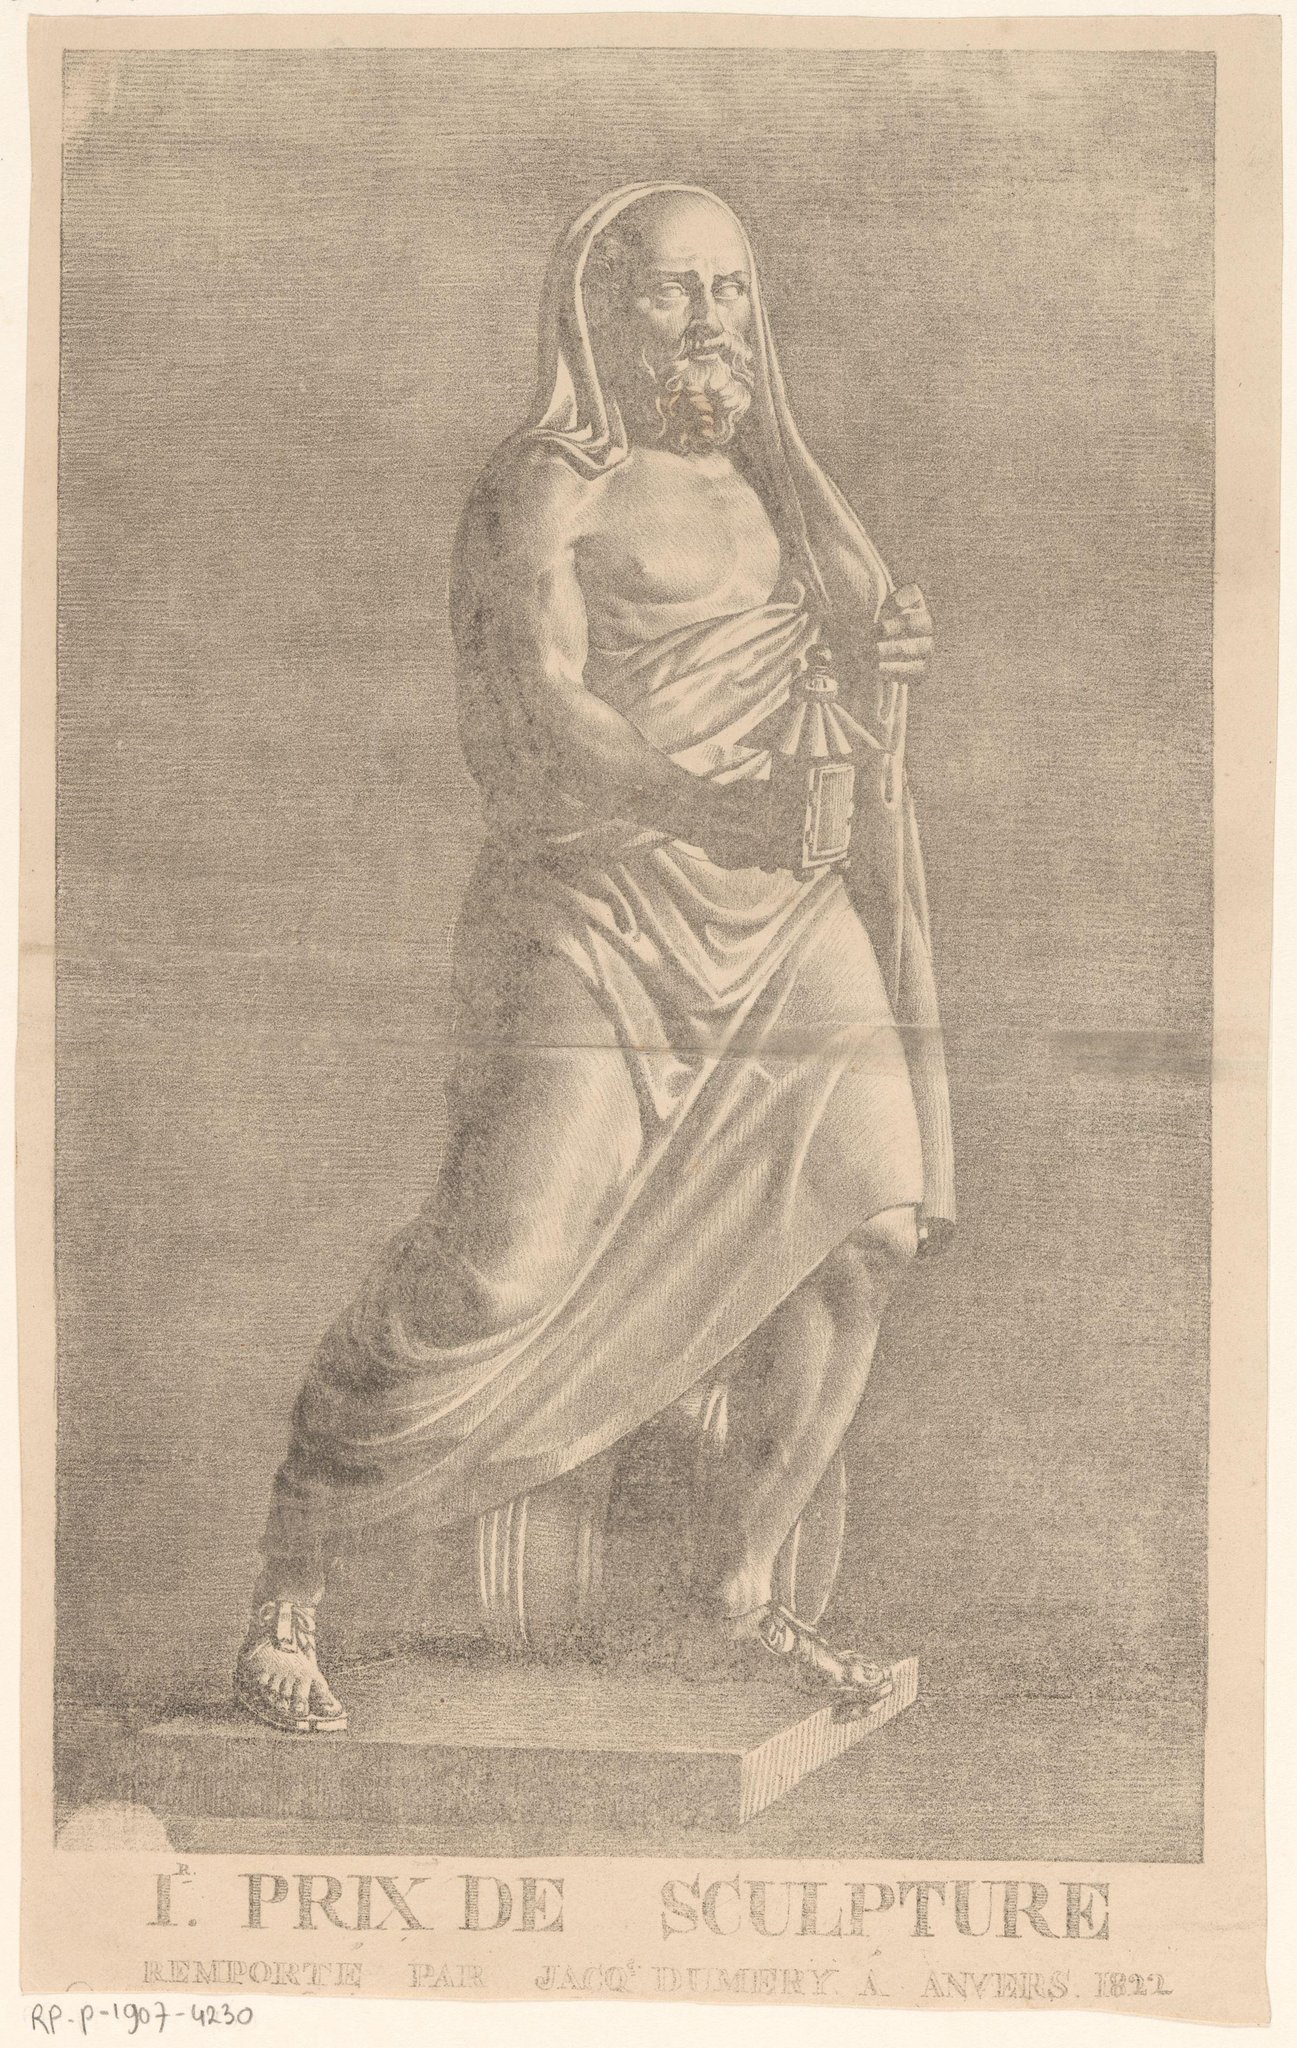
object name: print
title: Sculptuur van Diogenes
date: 1822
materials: paper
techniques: lithograph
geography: bruges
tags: diogenes, carrying a lighted lantarn by daylight, trying to find an honest man, usually in a crowded market-place, sculpture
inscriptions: collector's mark: Lugt 2228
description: Hij draagt een toga en heeft een lantaarn in zijn rechterhand. Achter hem ligt een ton. De sculptuur werd, volgens het onderschrift, gemaakt door Jacques Duméry (1775-1836). Hij won hiermee een eerste prijs in Antwerpen in 1822.